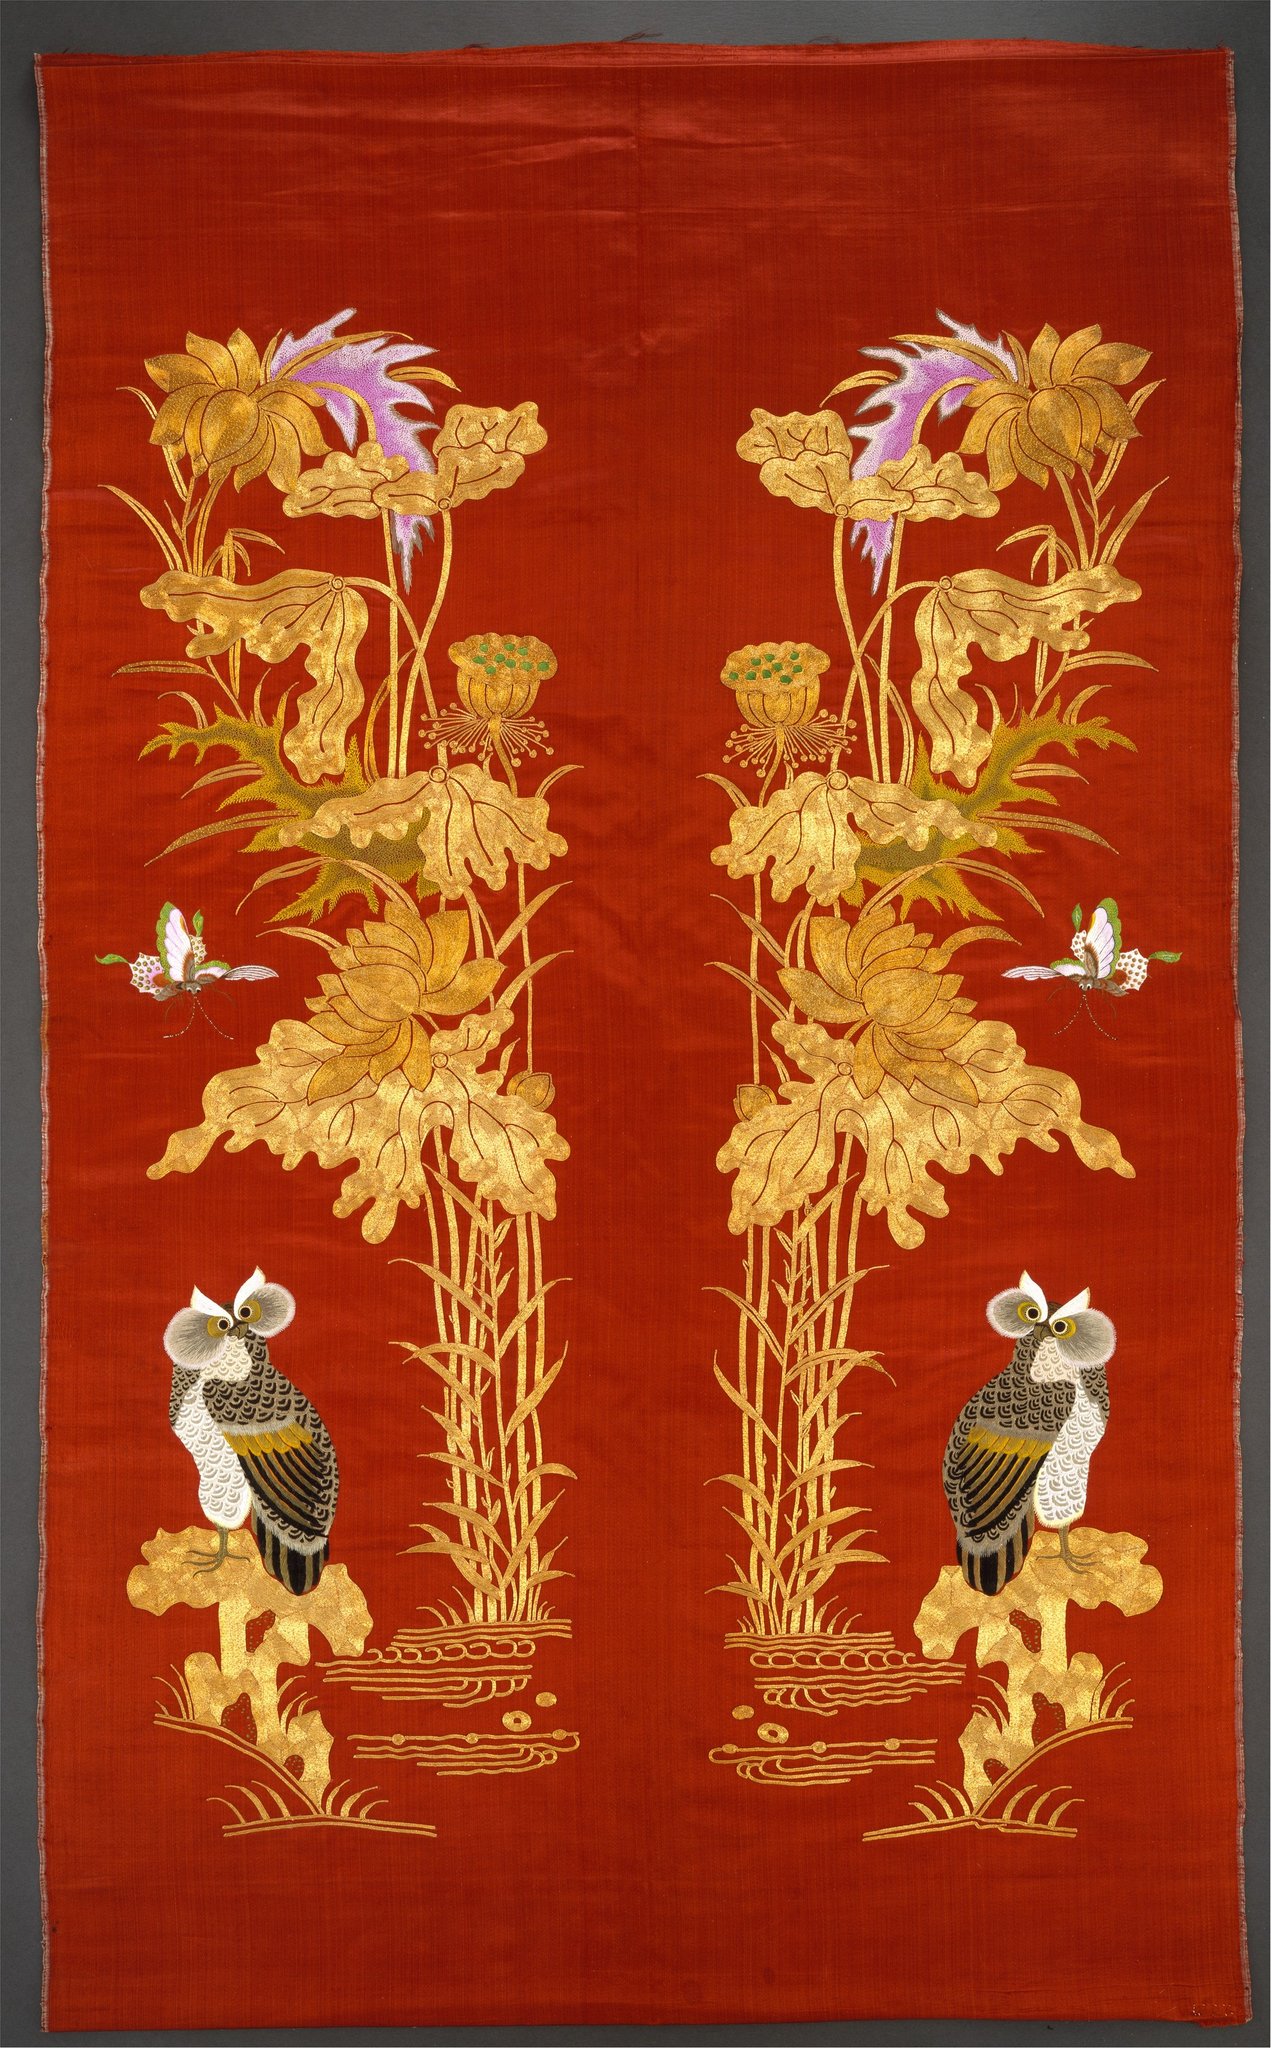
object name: length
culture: chinese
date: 1801-1900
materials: metal thread, silk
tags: owls,butterflies,flowers,plants,leaves